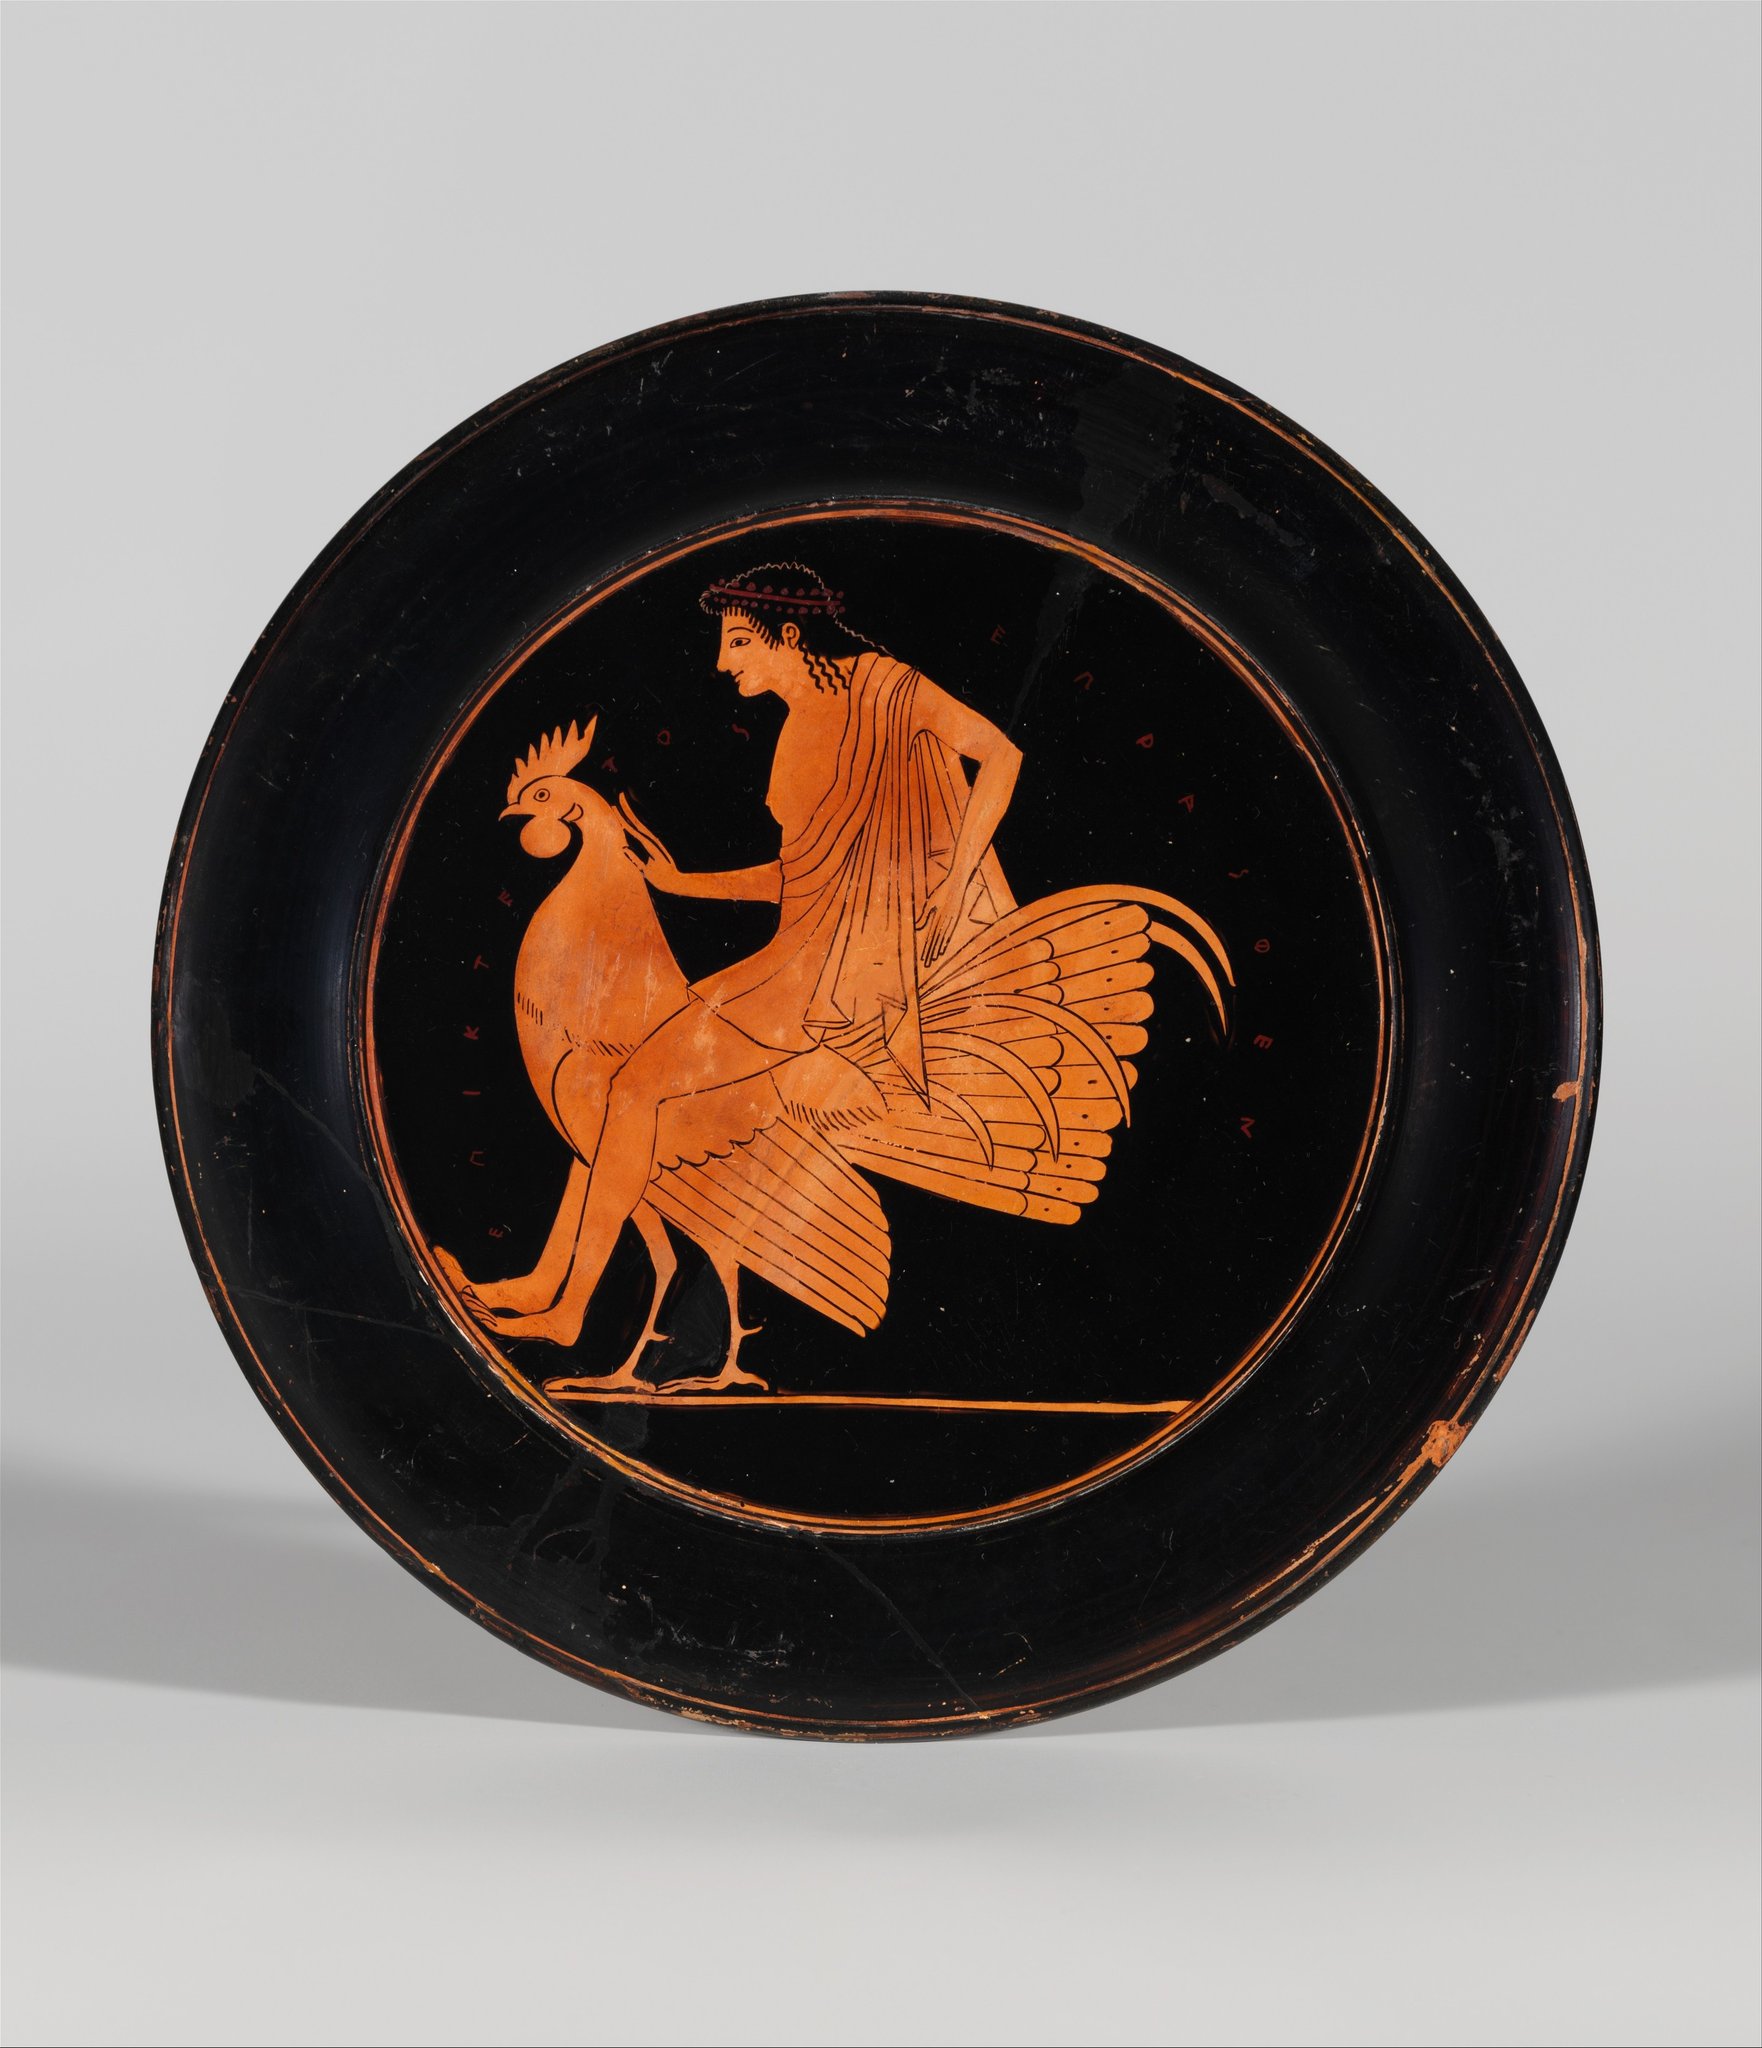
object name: plate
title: Terracotta plate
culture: greek, attic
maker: epiktetos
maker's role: artist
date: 520-510 BCE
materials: terracotta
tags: men,roosters